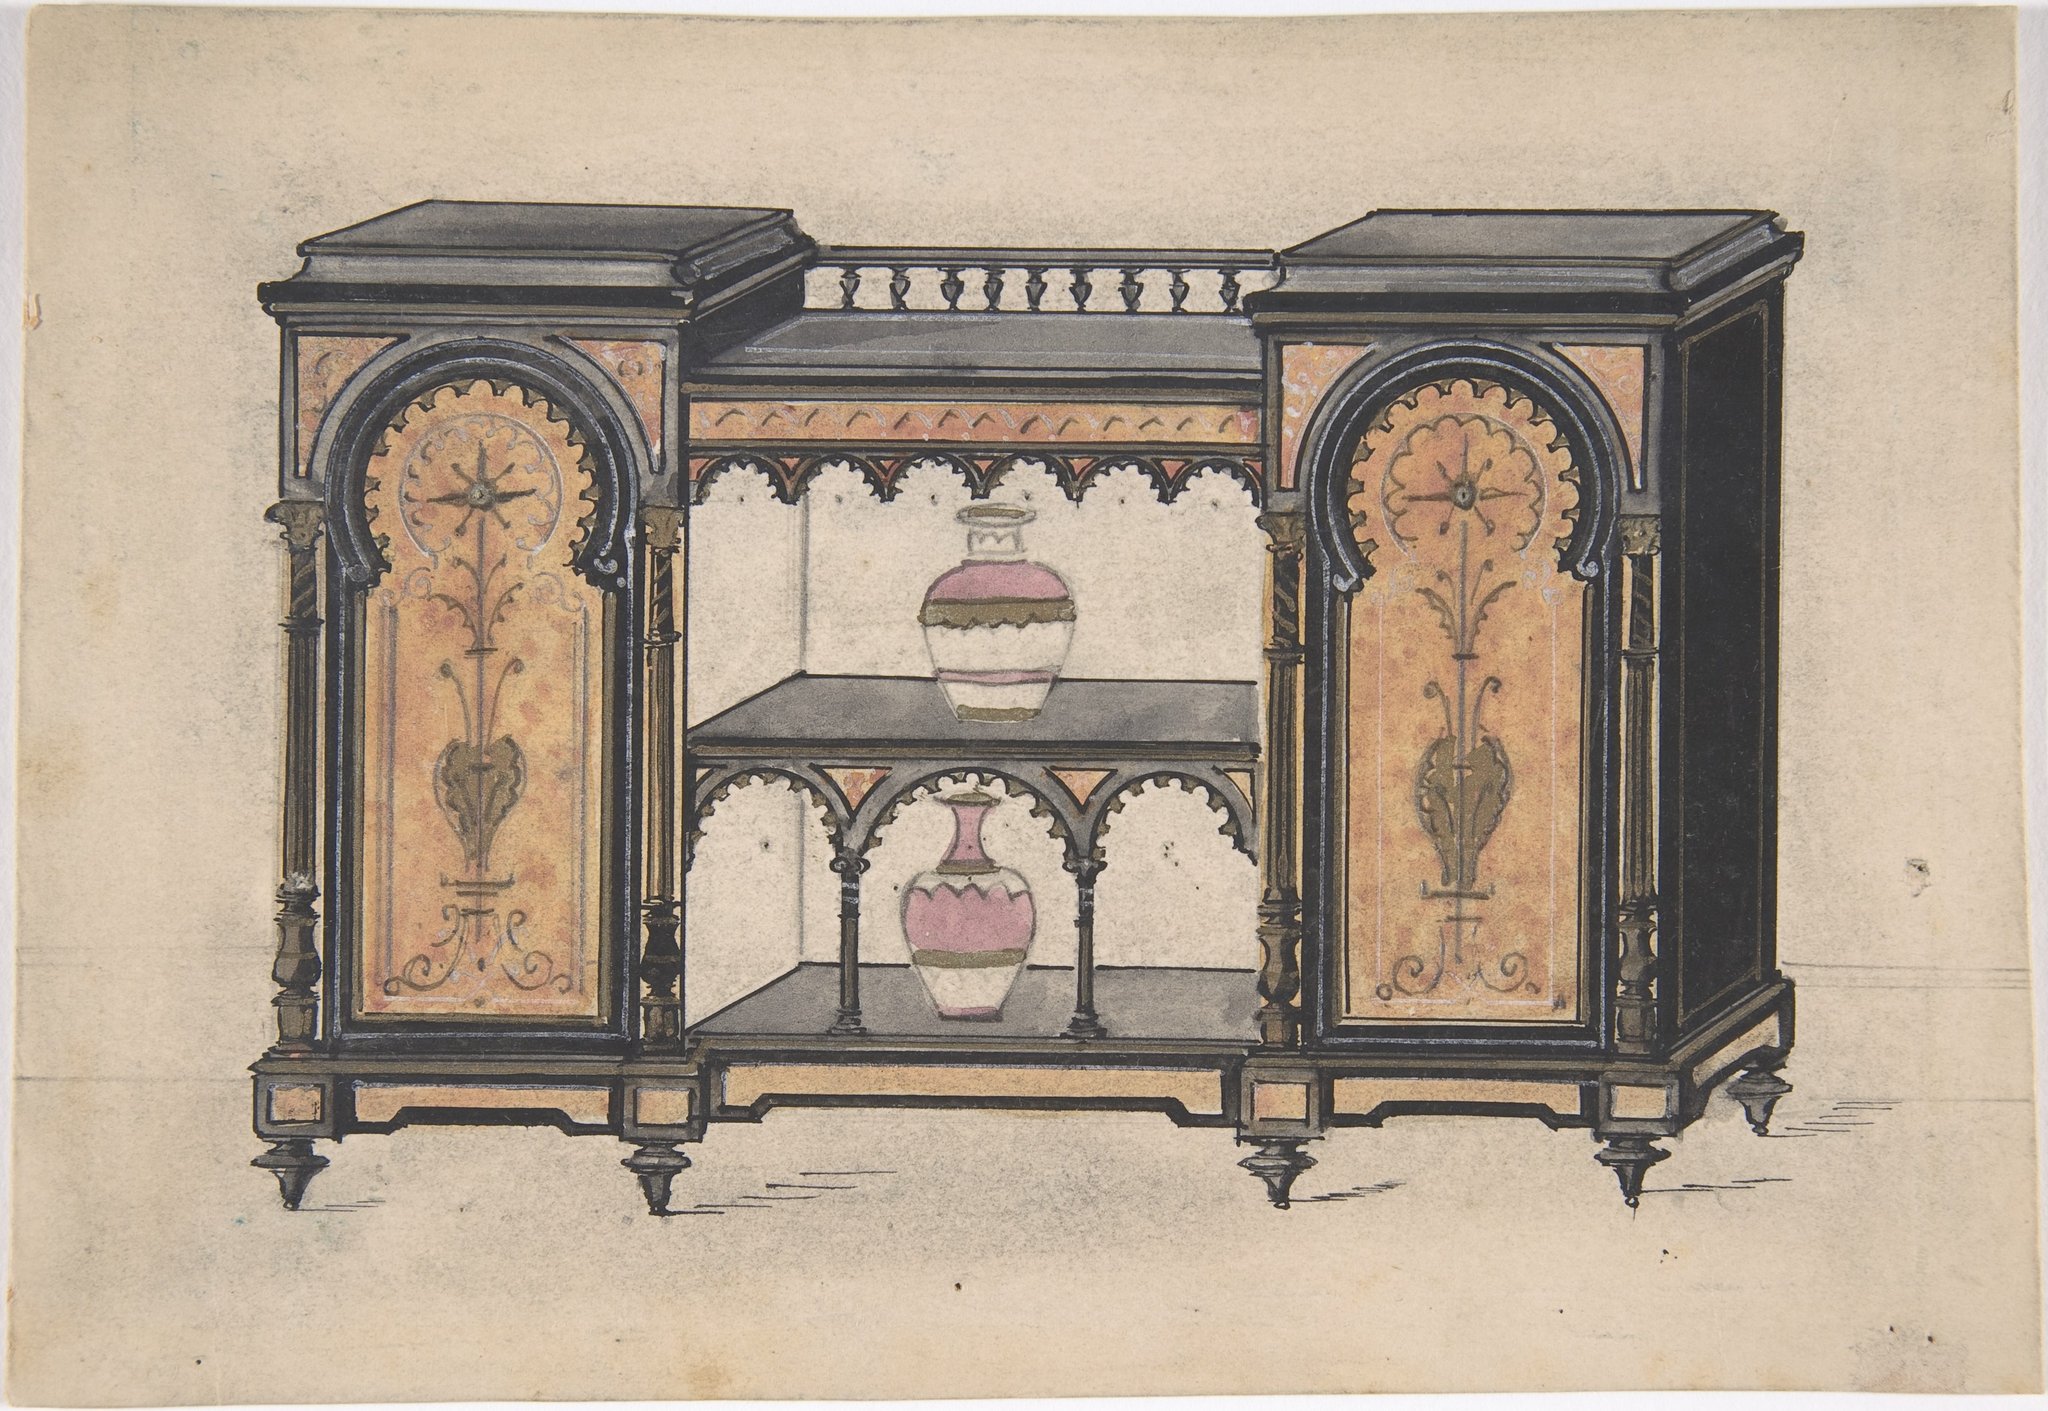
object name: drawing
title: Design for a Cabinet with Two Central Shelves and Arched Doors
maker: anonymous, british, 19th century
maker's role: artist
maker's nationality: british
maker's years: 1800-1900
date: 1801-1900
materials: ink, watercolor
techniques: pen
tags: cabinets